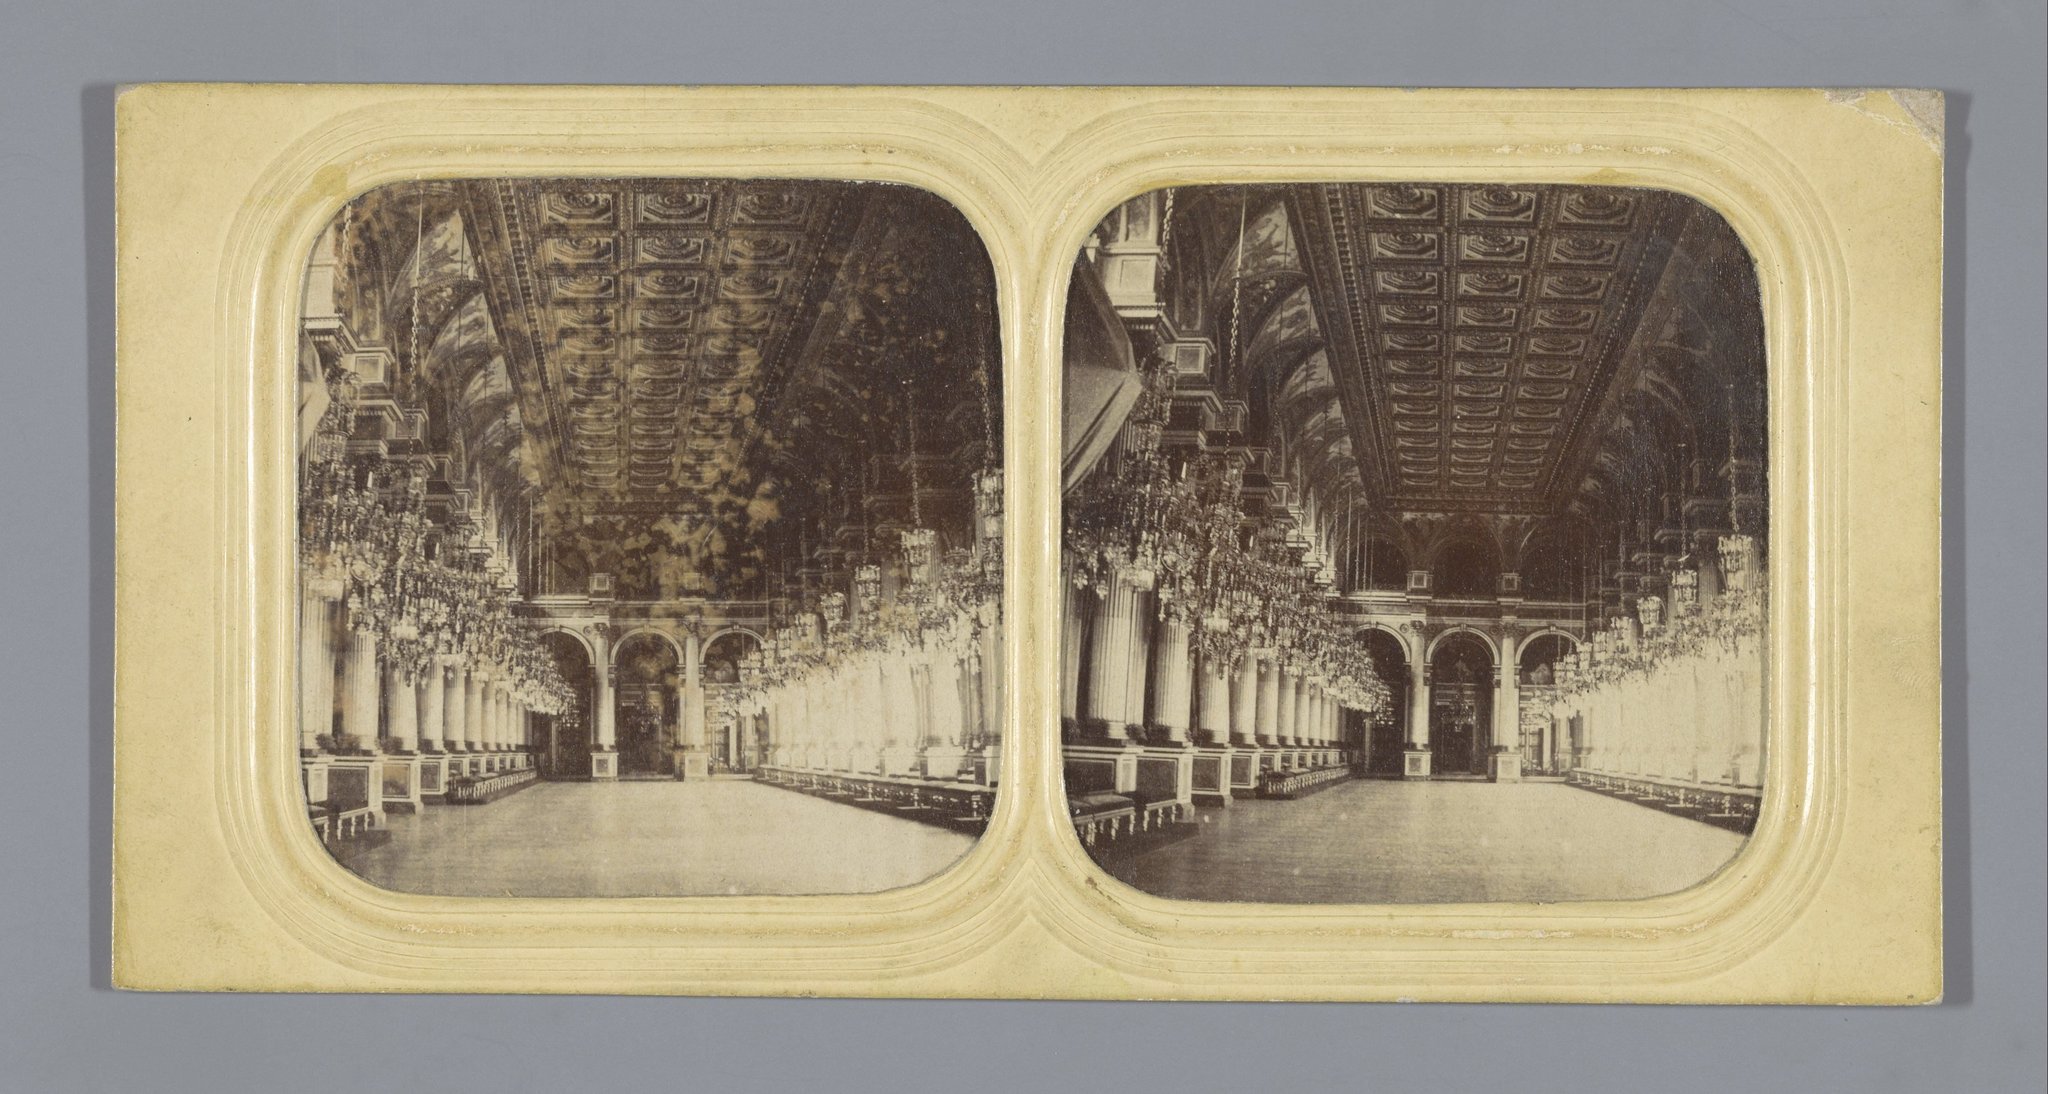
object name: tissue stereograph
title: Feestzaal in het Hôtel de Ville, Parijs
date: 1855-1875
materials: cardboard, paper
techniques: albumen print, hand coloring, perforating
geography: paris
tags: palace - aa - civic architecture: inside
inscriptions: retailer's mark: ‘Kunsthandlung/ Joh. Heinrigs/ in/ Cöln/ Hochstrasse 152./ Liefert alle im In- und Auslande/ erschienenen Kunstblätter.’, inscription: ‘M’